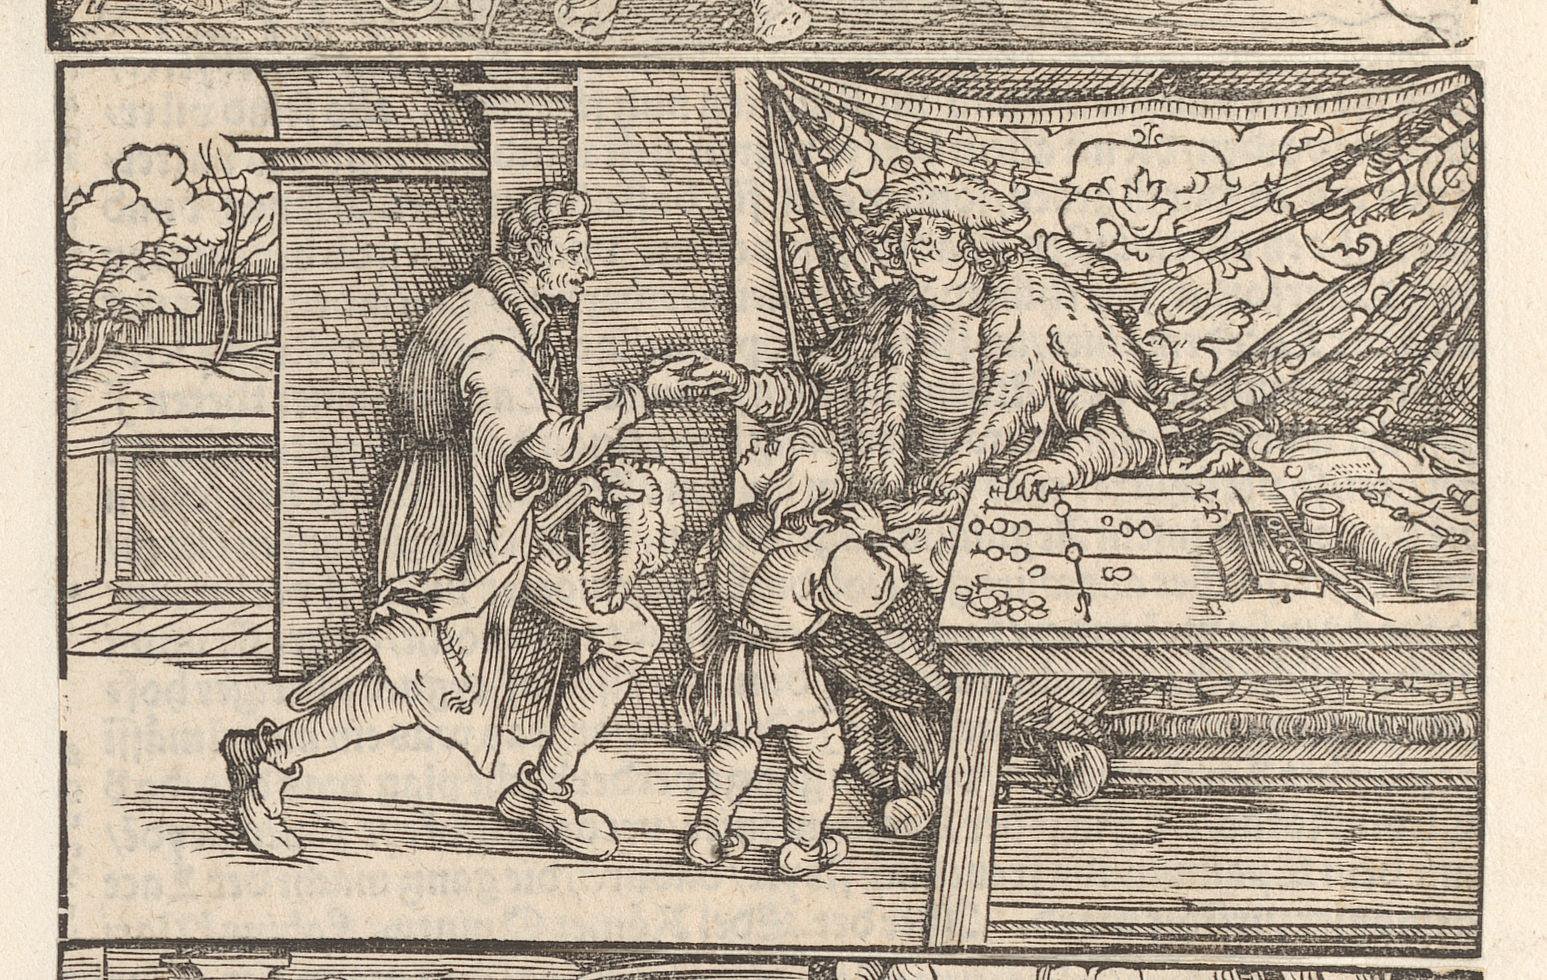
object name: album leaf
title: Geldschieter begroet man en een kind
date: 1514-1531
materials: paper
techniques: letterpress printing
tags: the foundling or the adopted child and its foster-parents, betrayal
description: Deze prent is gebruikt in: Cicero, Marcus Tulius. Officia M.T.C. Ein Buch so Marcus Tullius Cicero der Römer zu seynem (...). [Vertaald uit het Latijn door] Johann von Schwarzenberg. Augsburg: Heinrich Steiner, 1531.